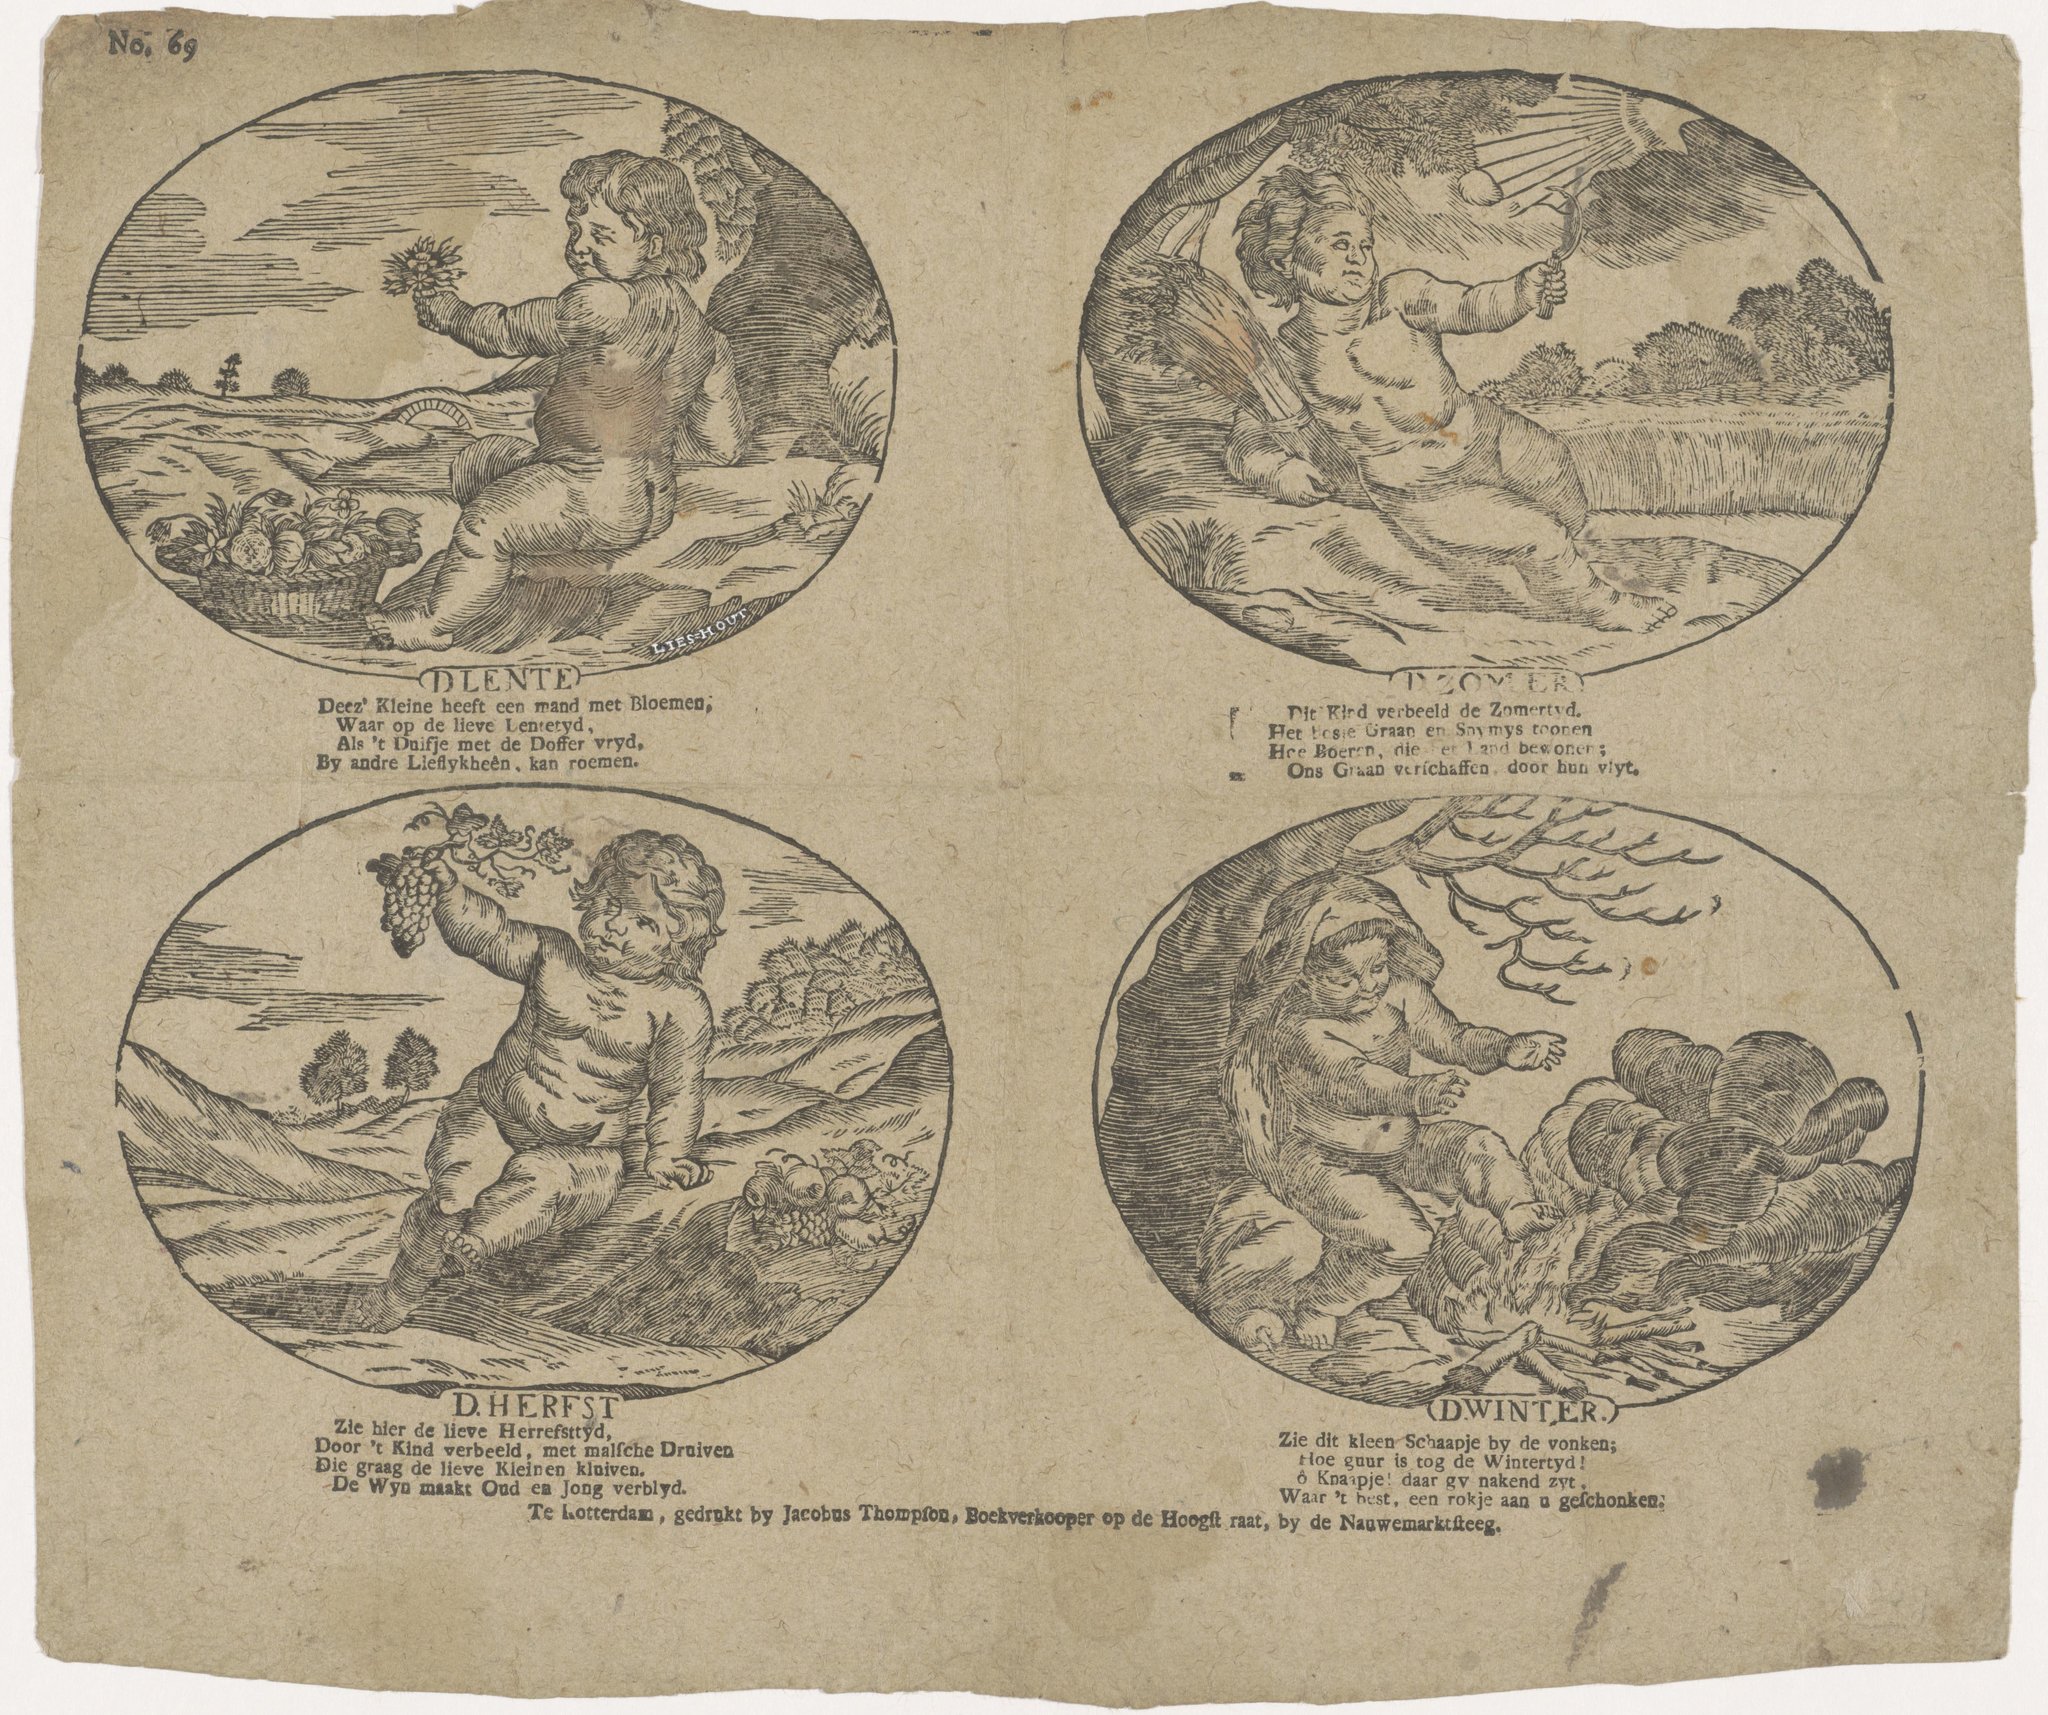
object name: popular print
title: De vier seizoenen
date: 1791-1812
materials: paper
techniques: colour, letterpress printing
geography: rotterdam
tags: year divided into four seasons, cupids: 'amores', 'amoretti', 'putti'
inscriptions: collector's mark: Lugt 2228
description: Blad met 4 ovale voorstellingen van putti met attributen die de vier seizoenen symboliseren: lente, zomer, herfst en winter. Onder elke afbeelding een vierregelig vers. Genummerd linksboven: No. 69.